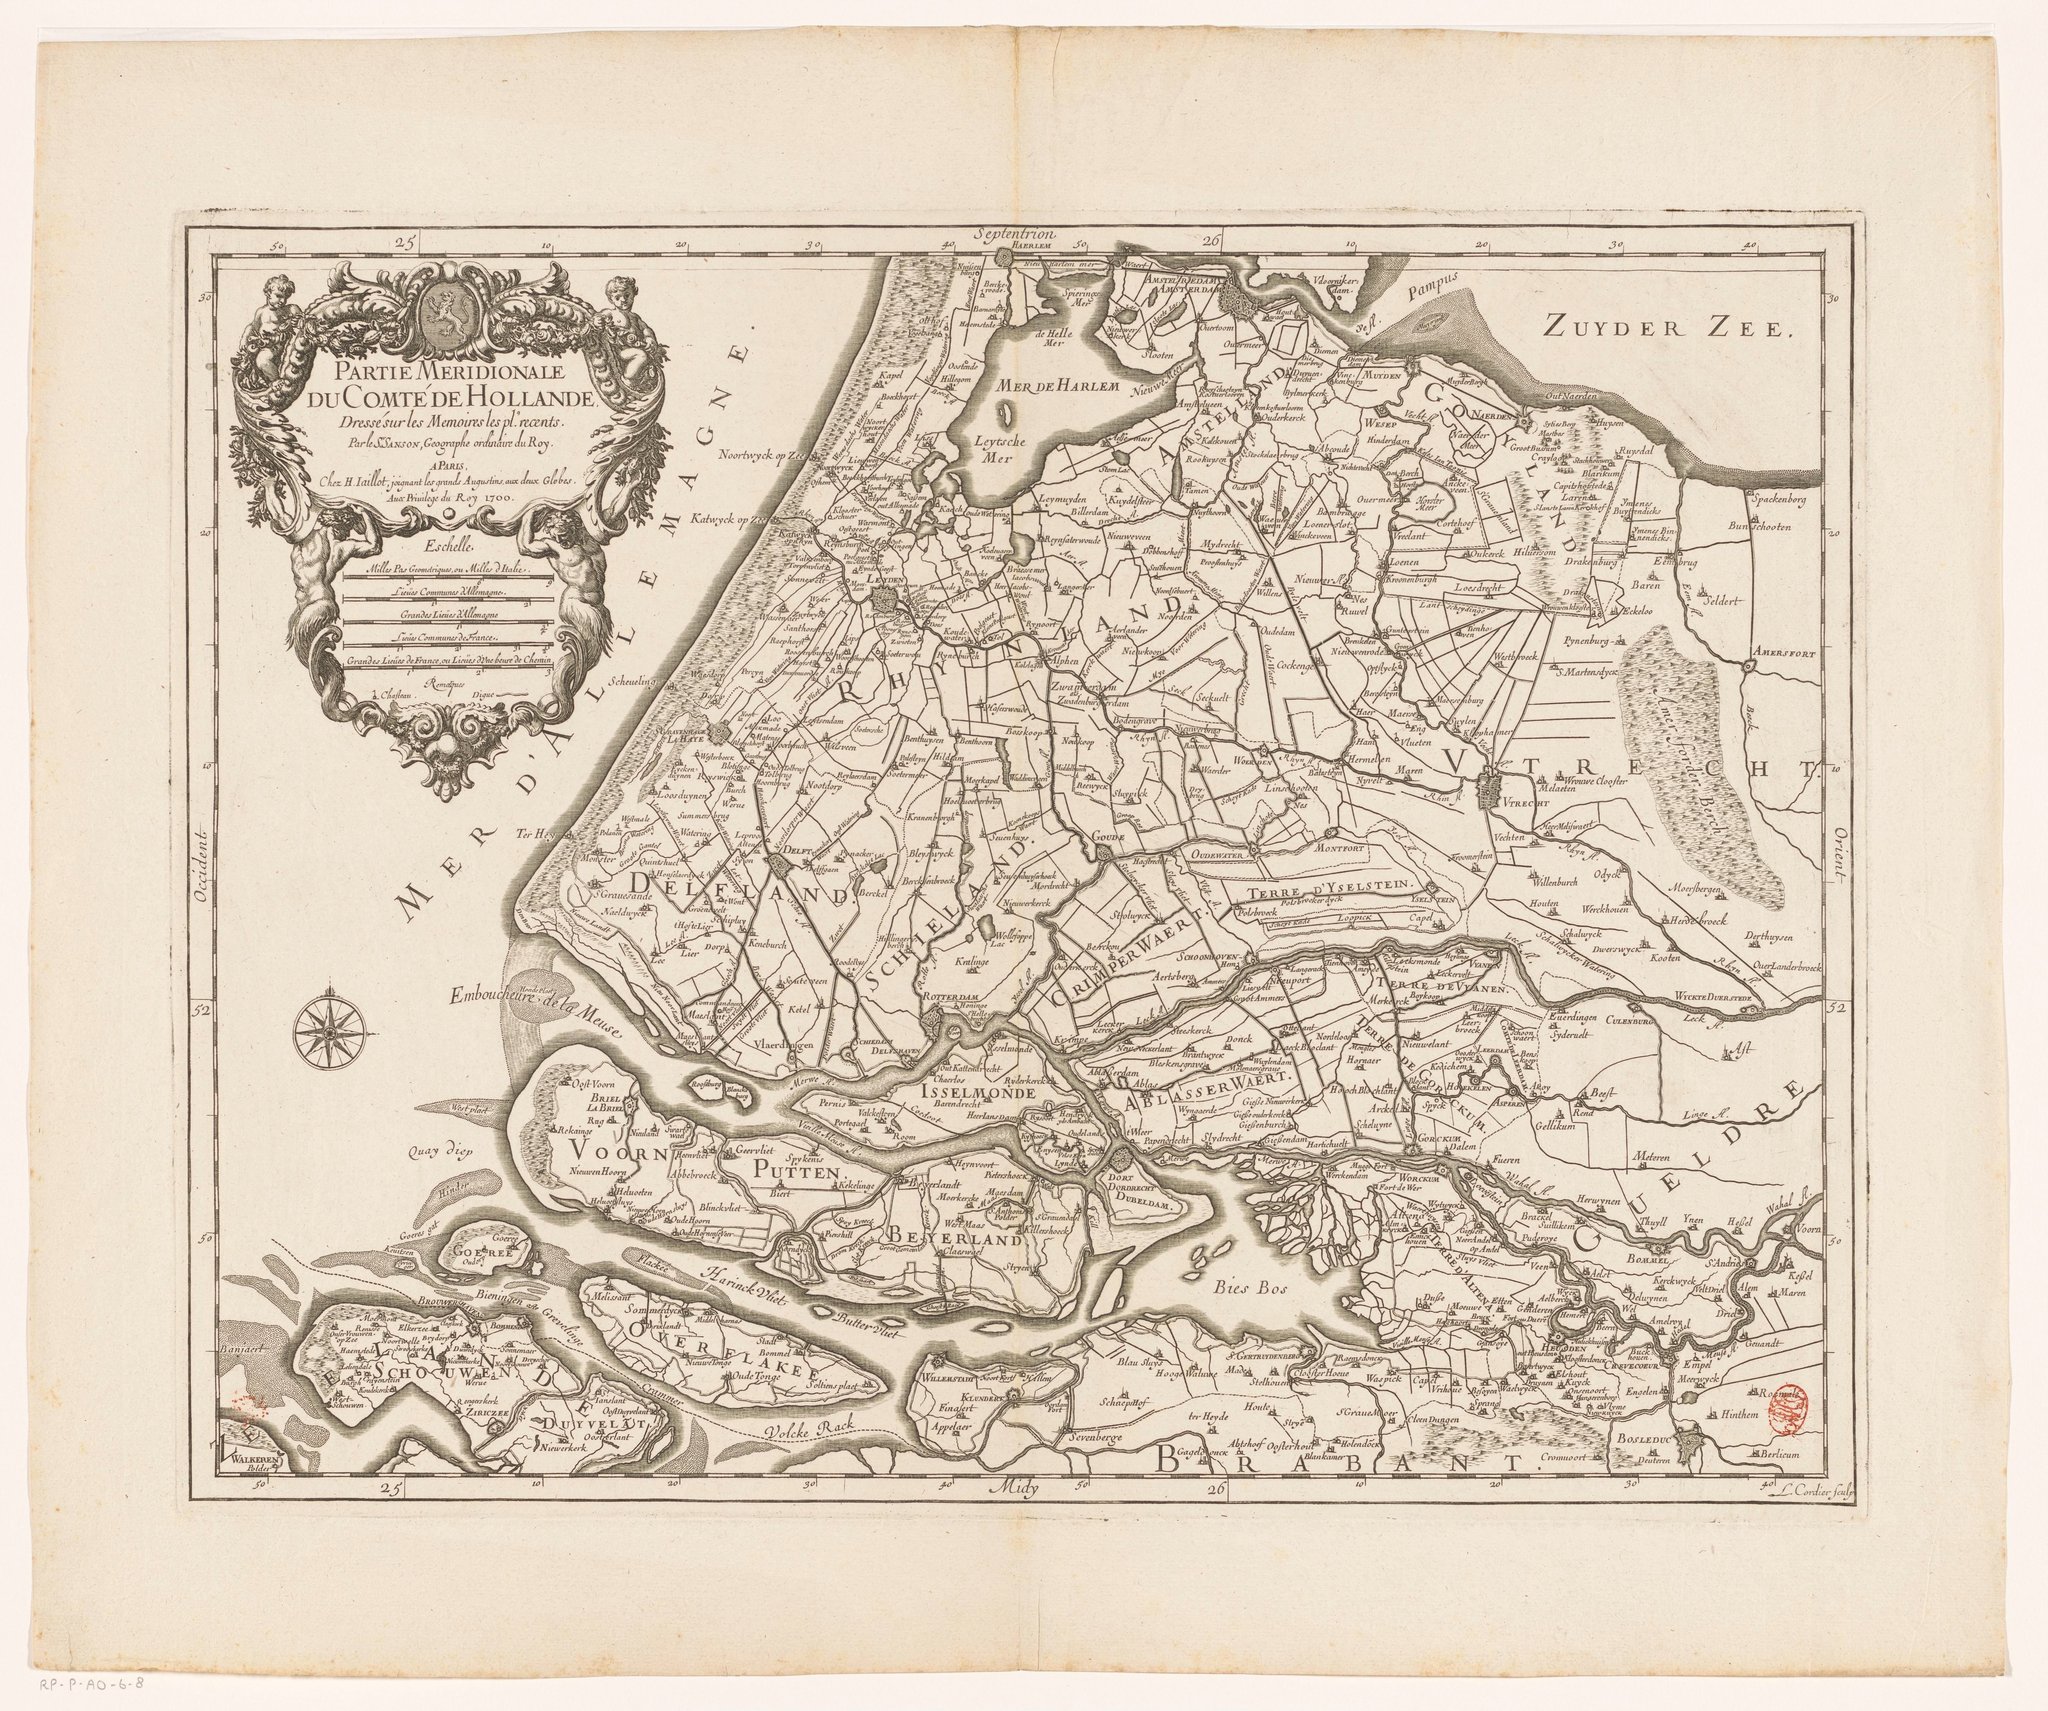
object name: map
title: Partie meridionale du comté de Hollande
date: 1700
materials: paper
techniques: engraving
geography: paris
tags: coat of arms (as symbol of the state, etc.), maps of separate countries or regions, holland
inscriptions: watermark, collector's mark: Lugt 195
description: Deze kaart vormt samen met RP-P-AO-6-7 een kaart van het graafschap Holland, maar werd ook los gebruikt als kaart van het zuidelijke deel van het graafschap. Prent ook gebruikt in: Atlas françois contenant les cartes geographiques dans lesquelles sont tres exactement remarquez les empires, monarchies, royaumes et estats (…). Parijs: Alexis Hubert Jaillot, 1700.